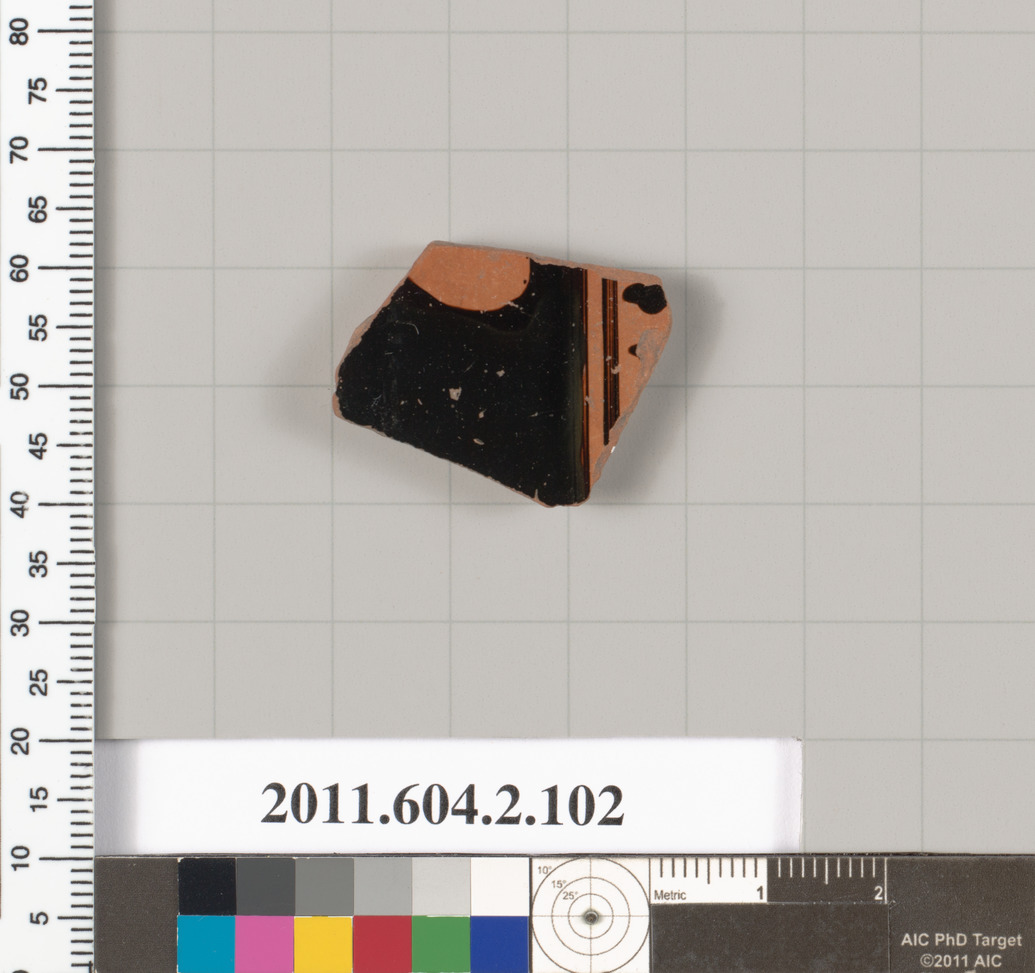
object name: pelike fragment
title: Terracotta fragment of a pelike (jar)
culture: greek, attic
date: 500-480 BCE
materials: terracotta